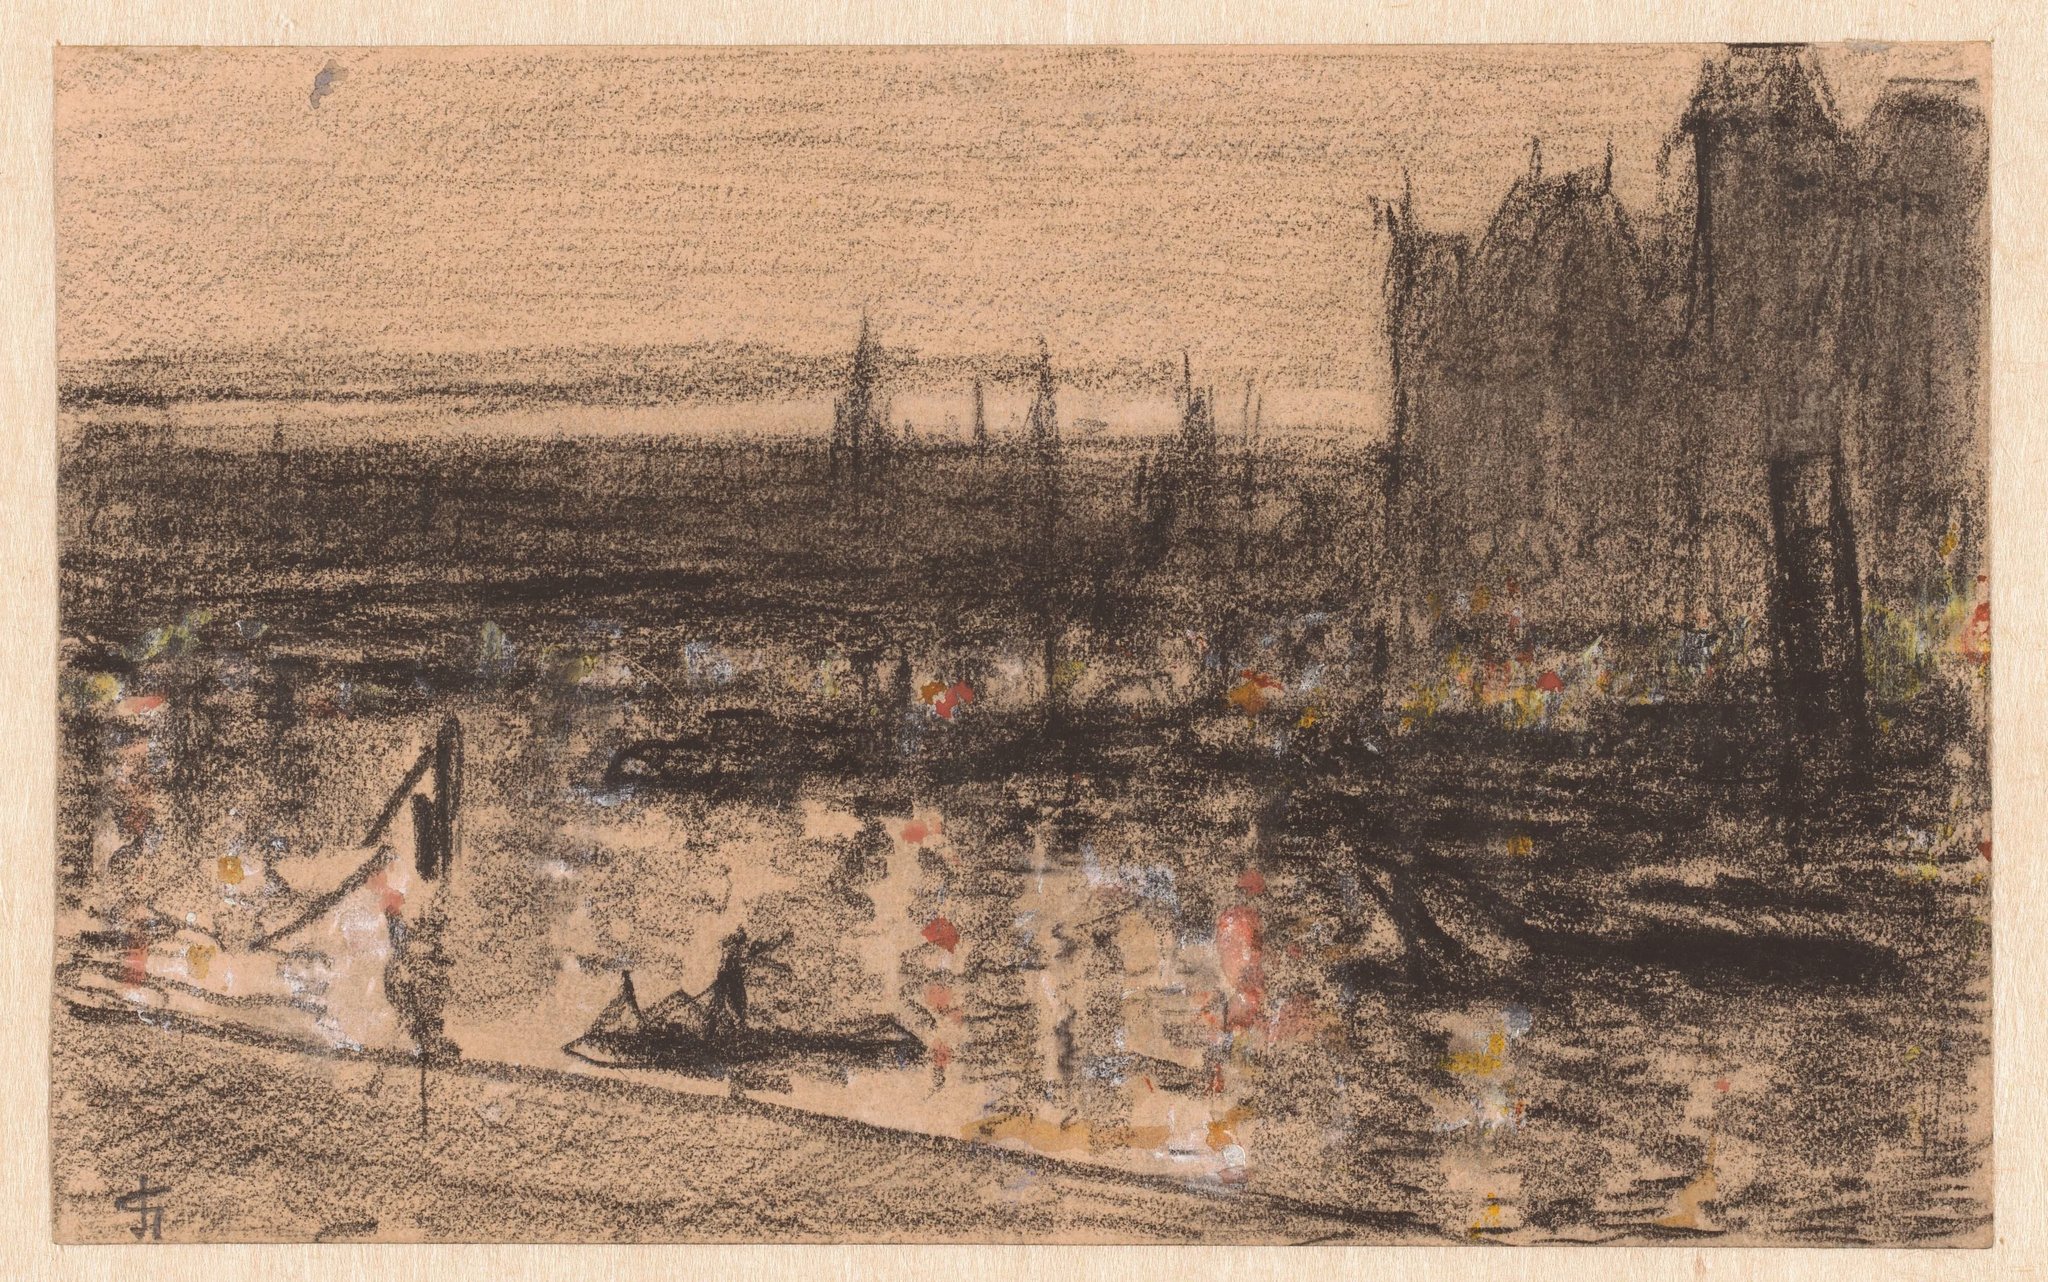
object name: drawing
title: Centraal station te Amsterdam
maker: carel nicolaas storm van s-gravesande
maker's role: draughtsman, print maker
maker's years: 1841-1924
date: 1902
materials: chalk, paper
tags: station; shelter (railway, tramway), amsterdam